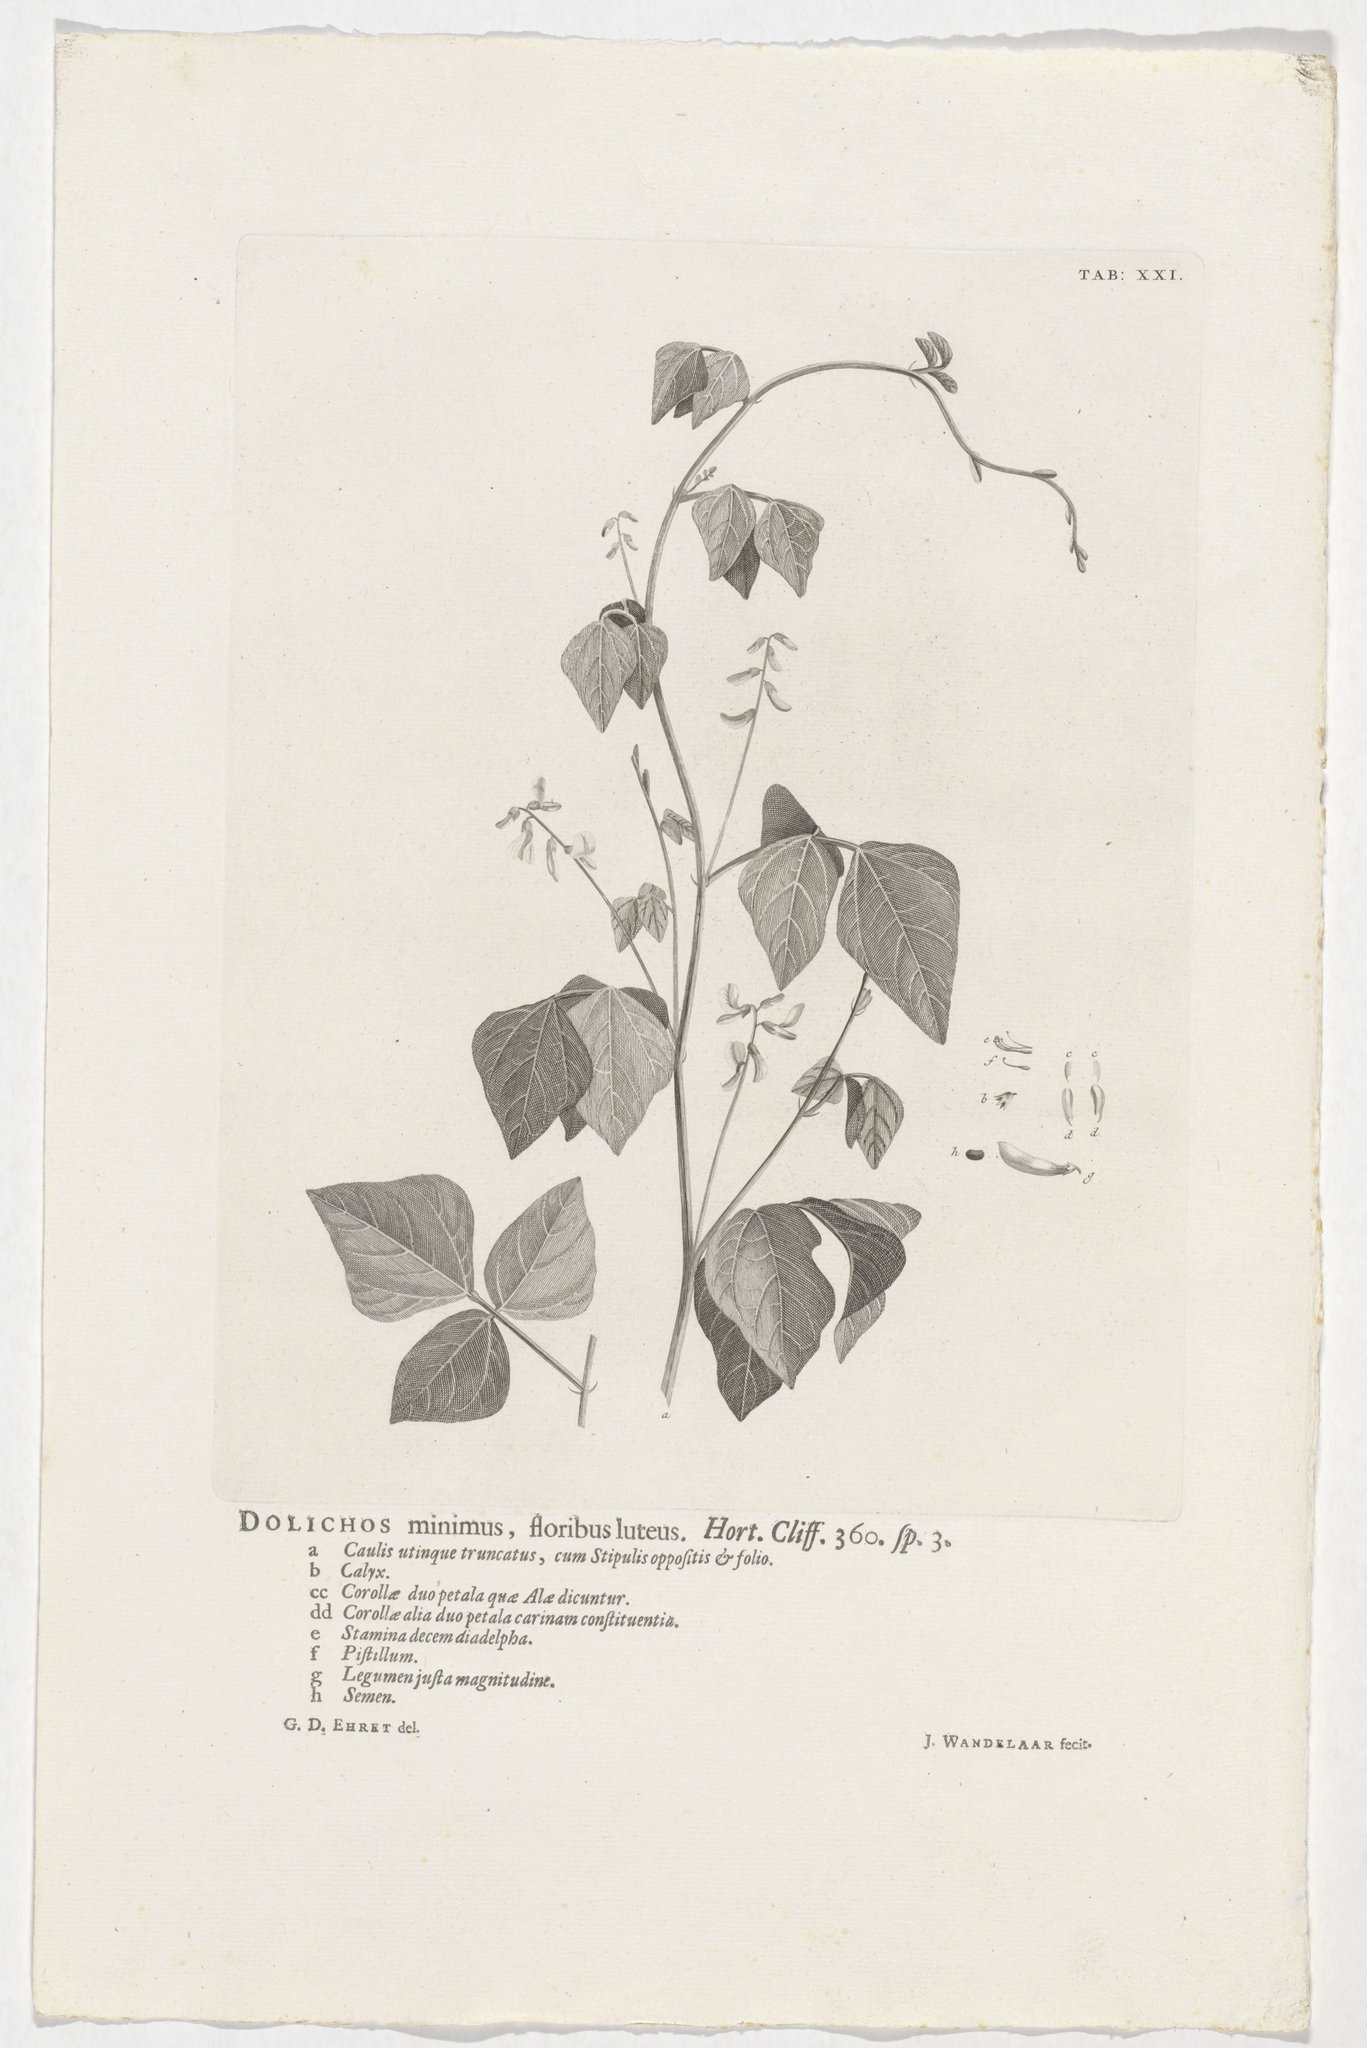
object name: book illustration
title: Rhynchosia minima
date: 1738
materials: paper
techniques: etching, letterpress printing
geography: warmond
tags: flowers, plants and herbs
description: Prent gebruikt als illustratie in: Linnaeus, Carolus. Hortus Cliffortianus plantas exhibens quas in hortis tam vivis quam siccis, Hartecampi in Hollandia, coluit (...) Georgius Clifford. Amsterdam: sine nomen, 1738.